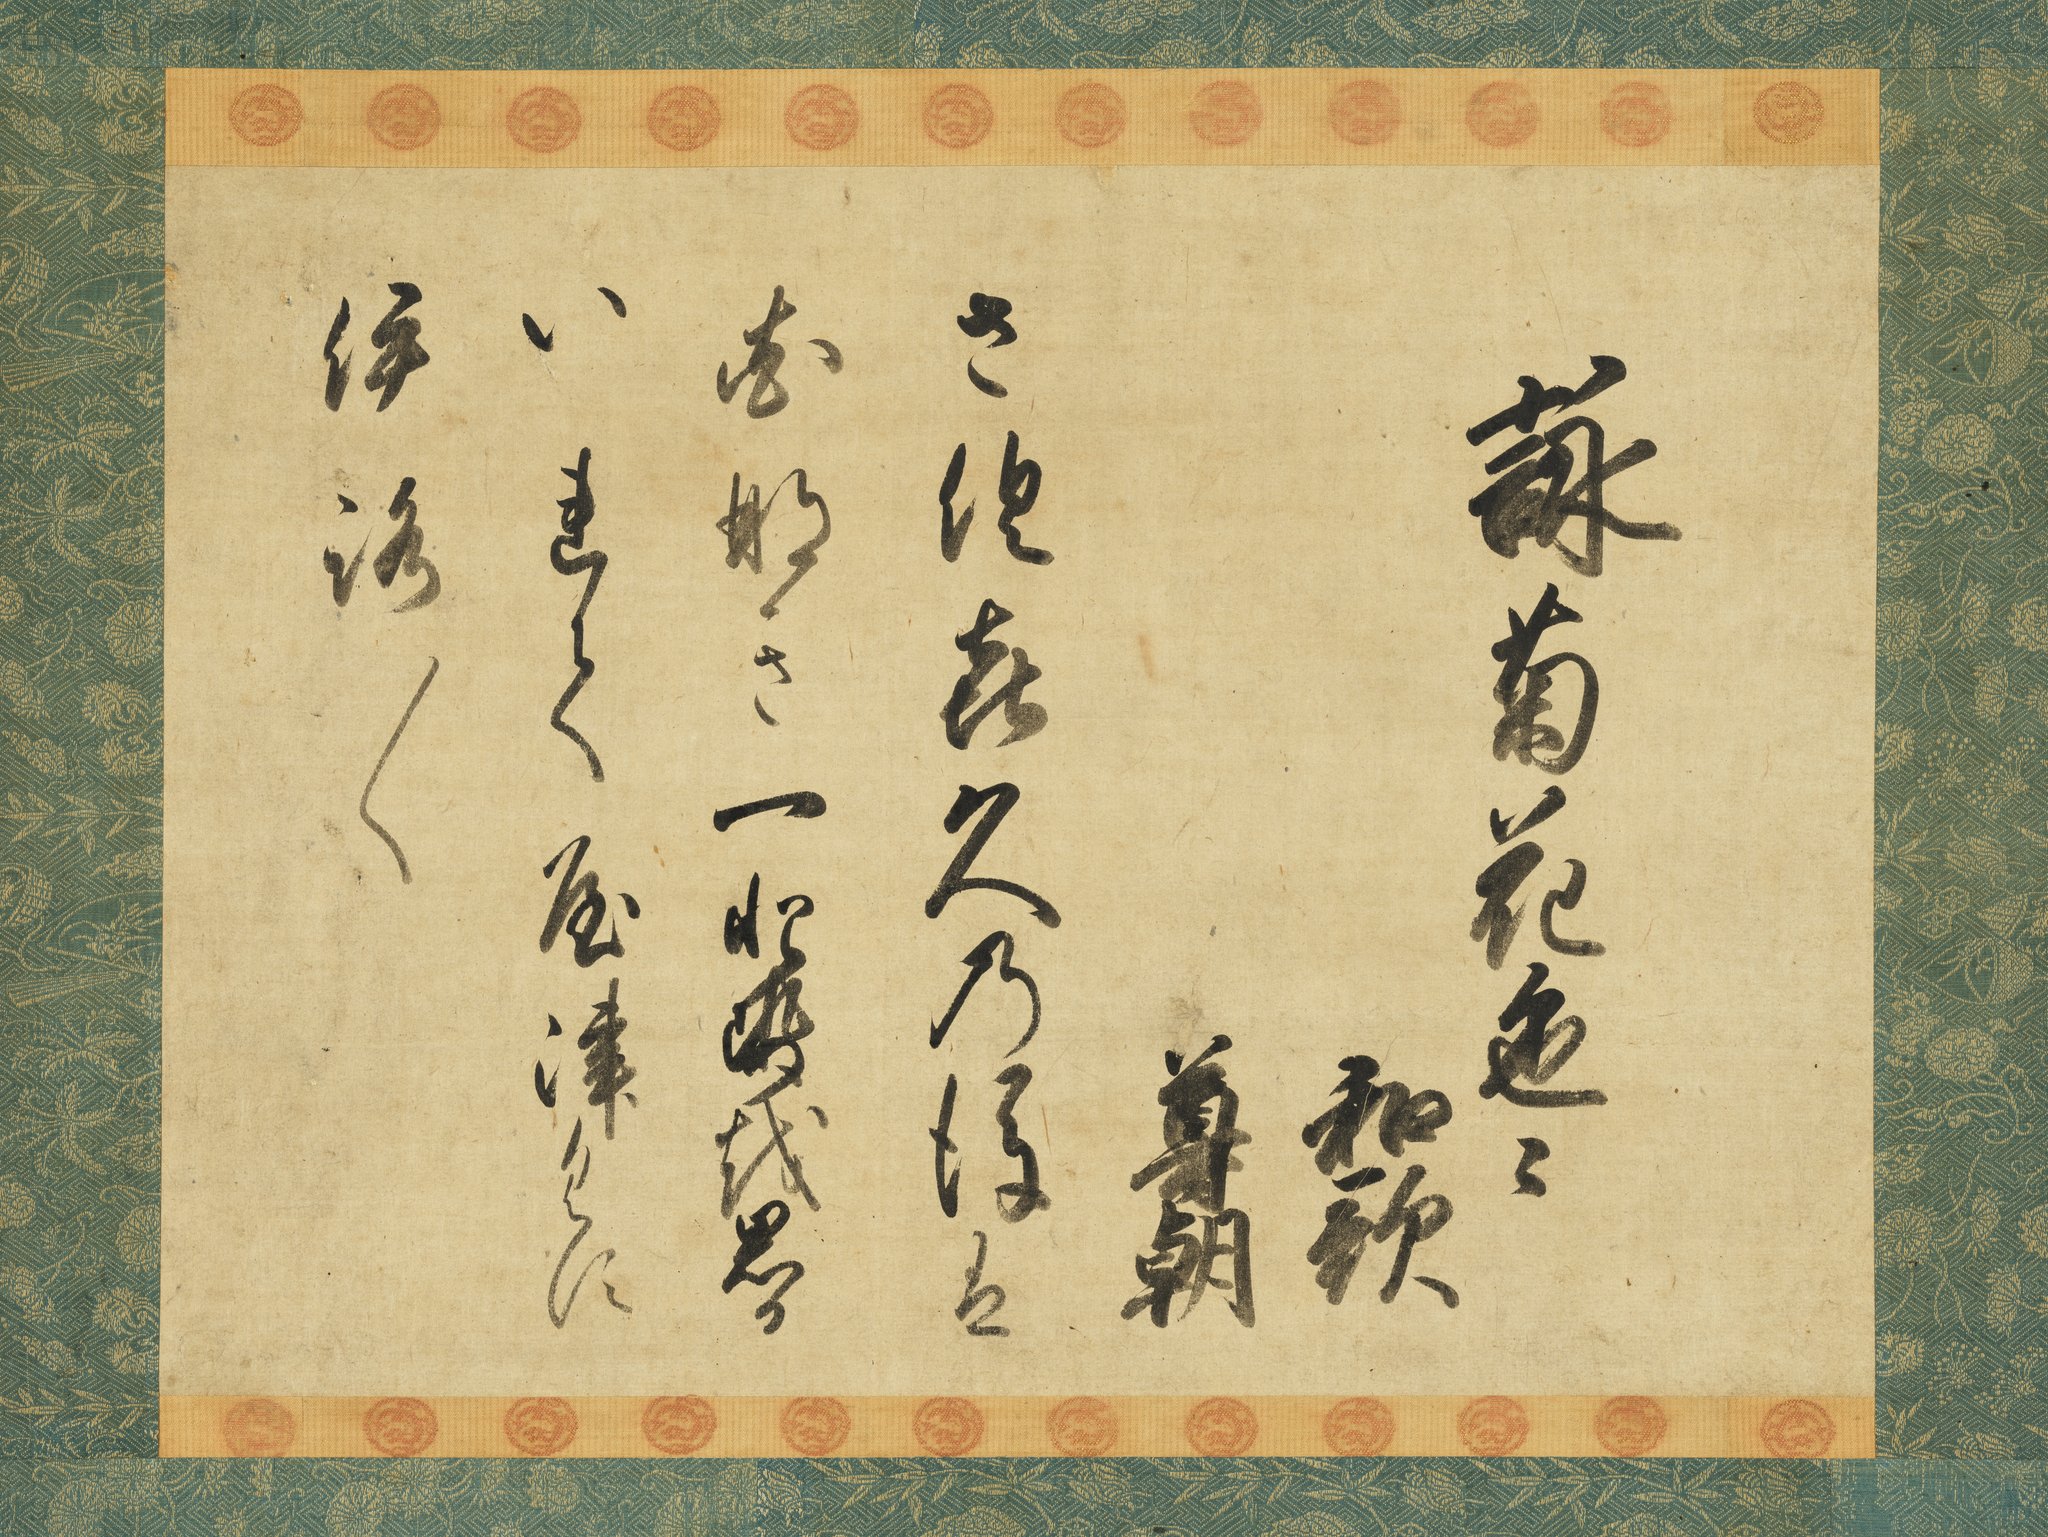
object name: hanging scroll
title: Waka Poem on Chrysanthemums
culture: japanese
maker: shōren’in sonchō hosshinnō 青蓮院尊朝法親王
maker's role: artist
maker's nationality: japanese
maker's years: 1552-1597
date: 1567-1600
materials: ink, paper